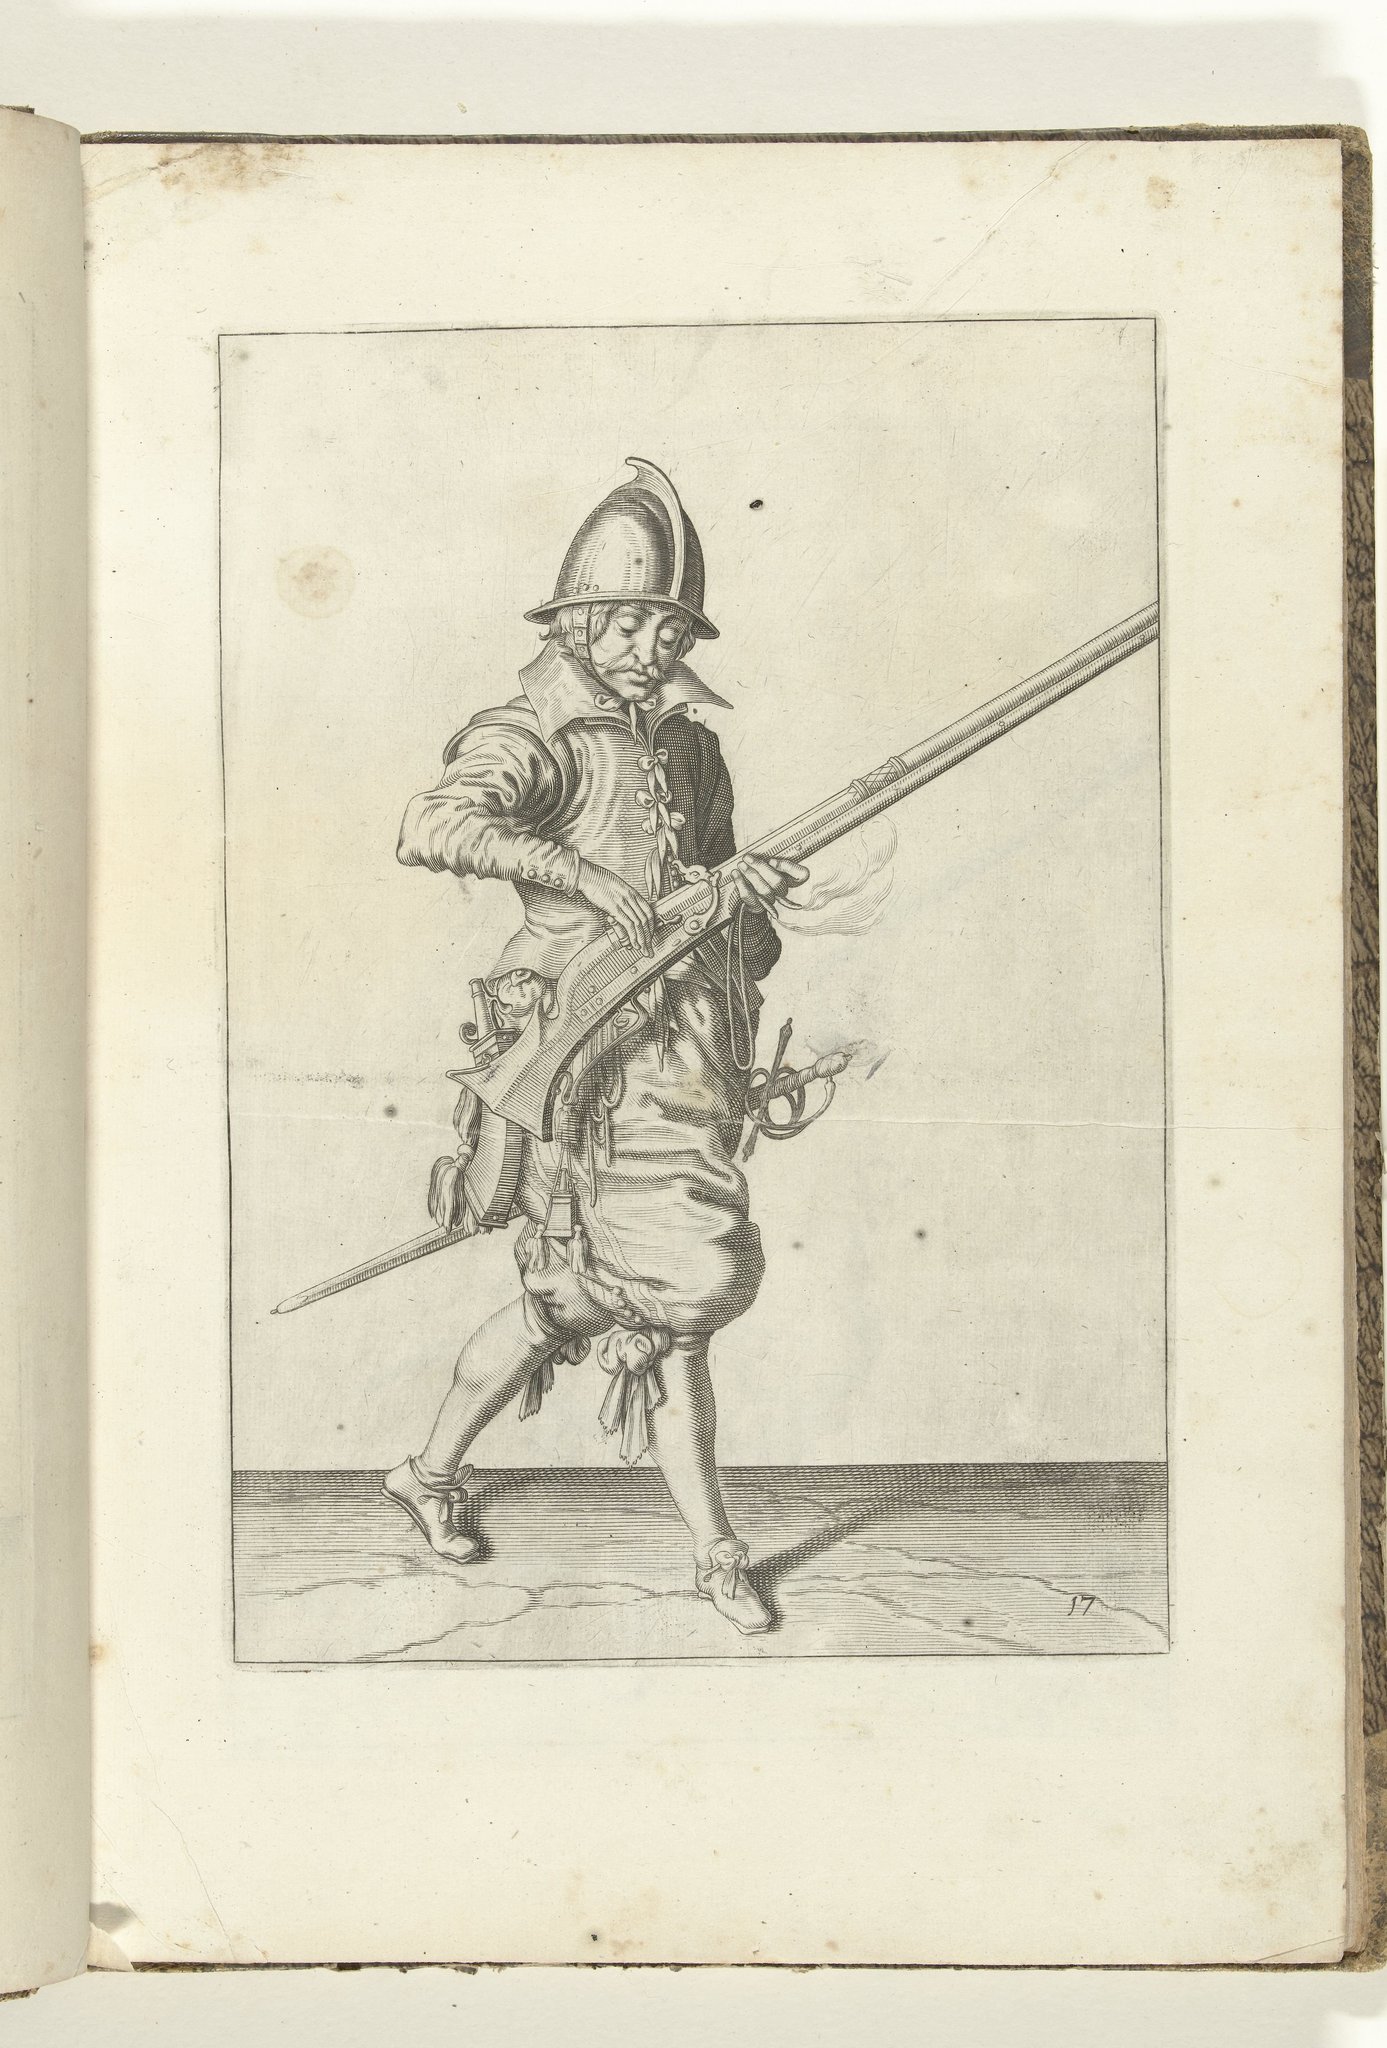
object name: print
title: Soldaat die de pan van zijn roer sluit (nr. 17), ca. 1600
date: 1597-1608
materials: paper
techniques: engraving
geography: northern netherlands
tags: the hague, maurice (prince of orange), handling of weapons ~ military training, weapons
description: Een soldaat, ten voeten uit, naar rechts, die met zijn rechterhand de pan (het kruitreservoir) van zijn roer (een bepaald type vuurwapen) sluit (nr. 17), ca. 1600. In zijn linkerhand behalve het roer ook een brandende lont. Plaat 17 in de instructies voor het hanteren van de roer: Brief enseignement, sur la representation des figures, du droit maniement de l'Harquebuse. Onderdeel van de illustraties in een Franse editie van J. de Gheyns Wapenhandelinghe: J. de Gheyn, Maniement d'armes, d'arquebuses, mousquetz et piques : en conformité de l'ordre de Mour le Prince Maurice, Prince d'Orange, Amsterdam 1608. Krijgswezen rond 1600.